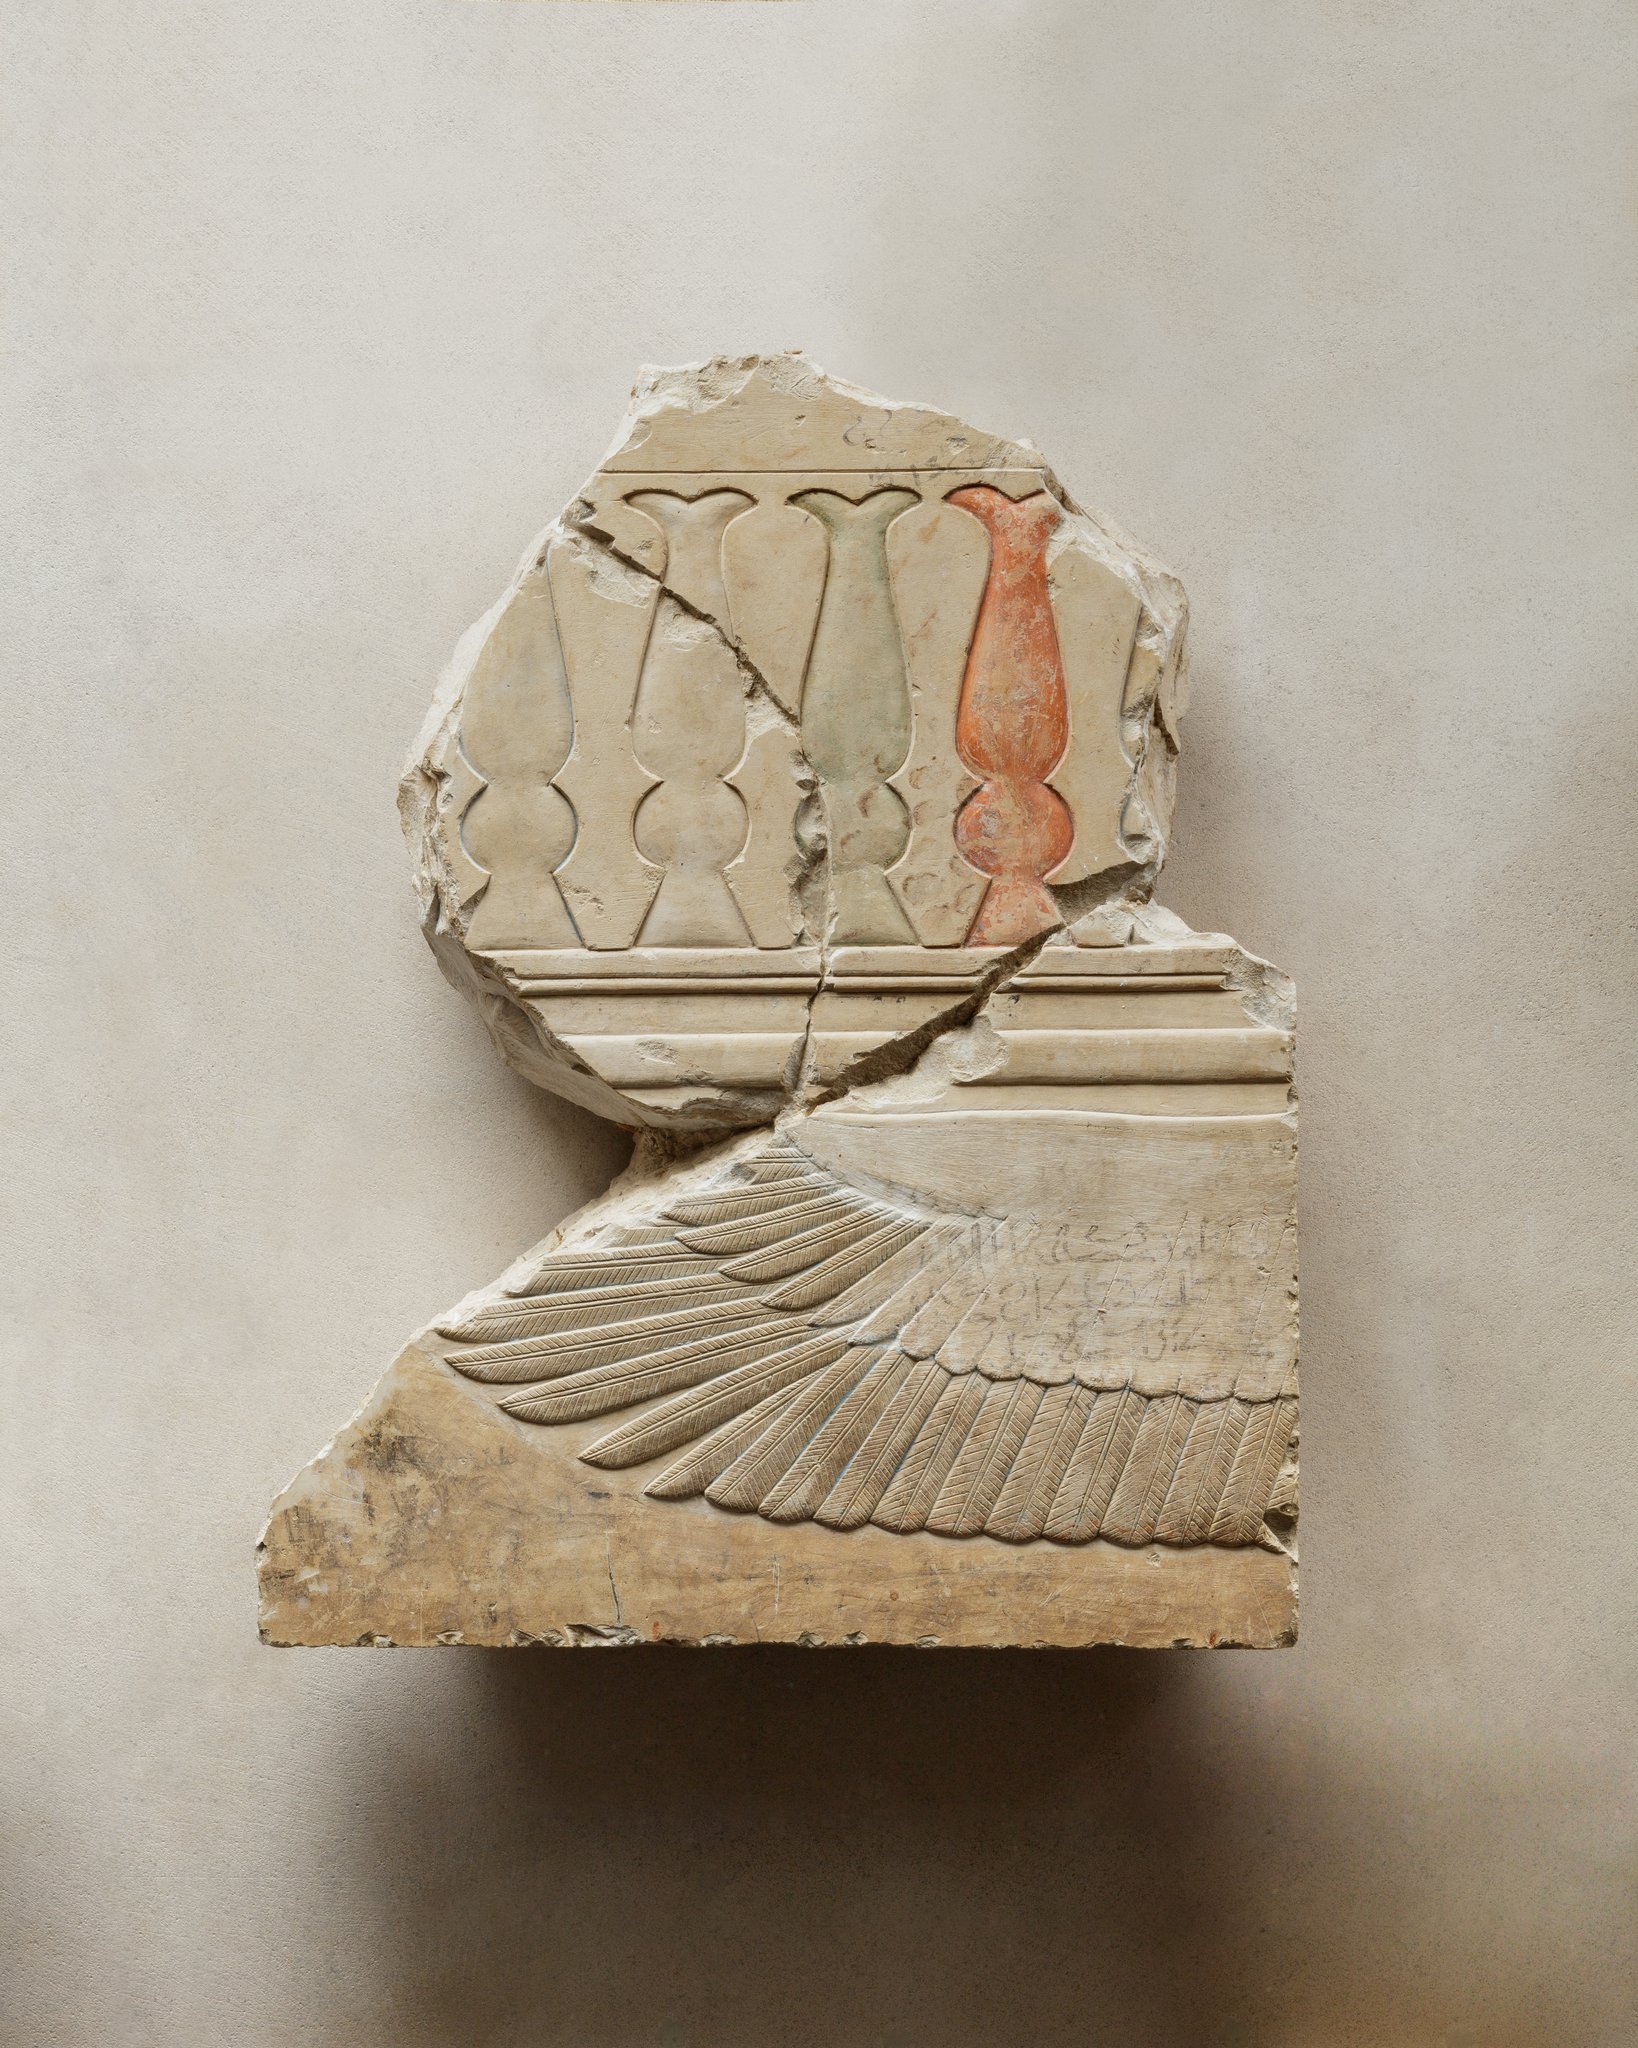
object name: relief, part of scene with king and queen, neferu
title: Relief preserving part of a scene with the king and queen - see 26.3.353-4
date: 2051-2030 BCE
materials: limestone, paint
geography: egypt